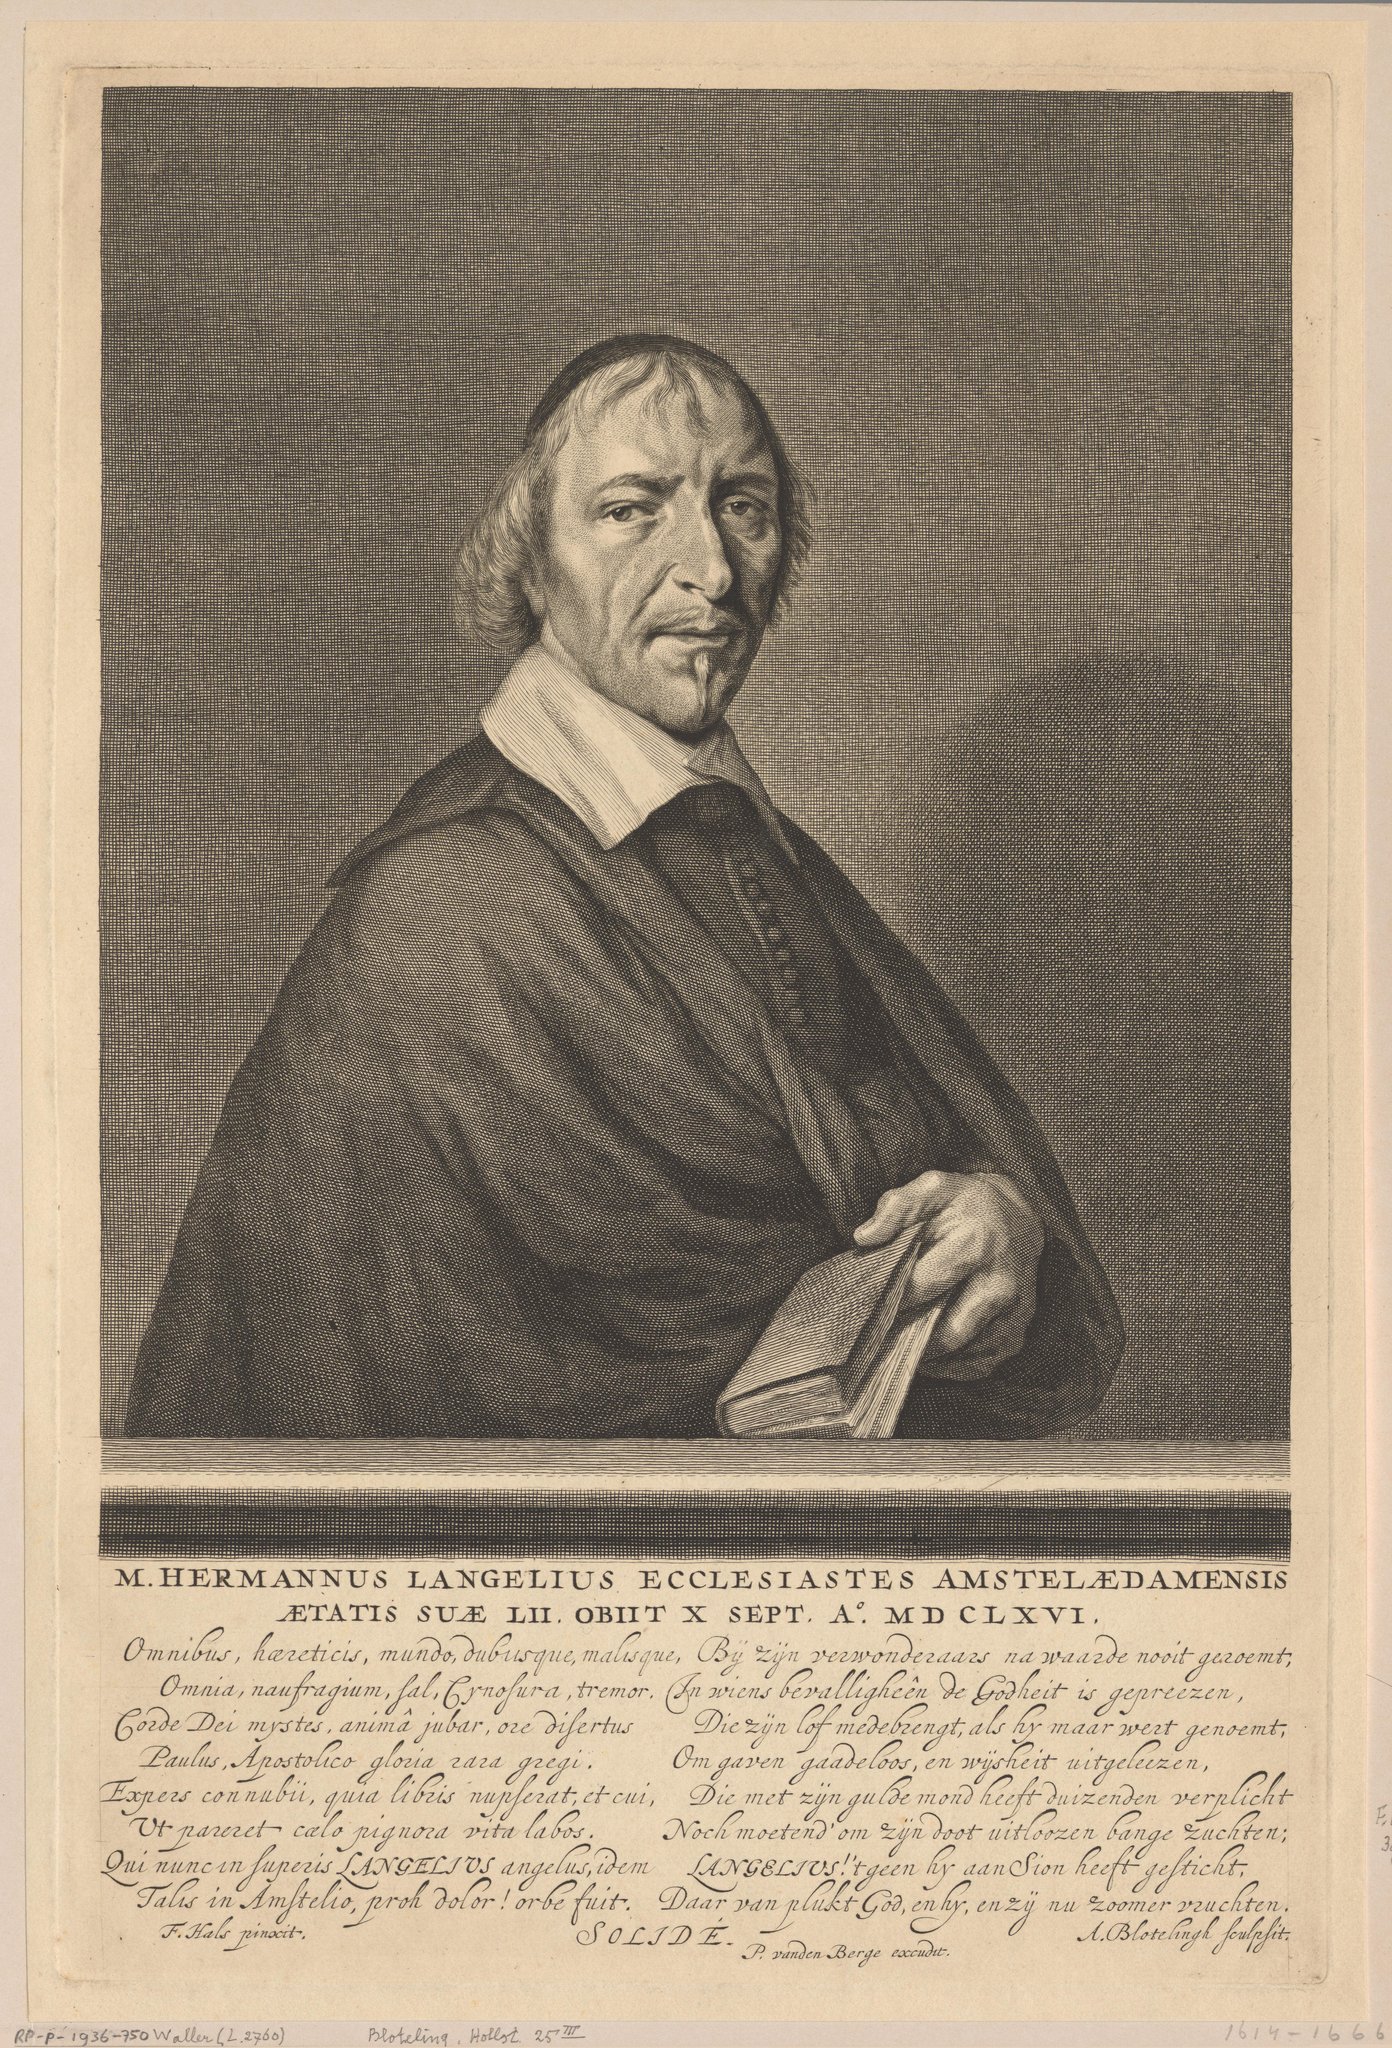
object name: print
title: Portret van Hermanus Langelius op 52-jarige leeftijd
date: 1694-1737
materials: paper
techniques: engraving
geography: amsterdam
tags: historical persons, book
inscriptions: collector's mark: Lugt 2228, collector's mark: Lugt 2760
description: De uitgever Pieter van den Berge gaf de prent waarschijnlijk na het overlijden van Bloteling uit.